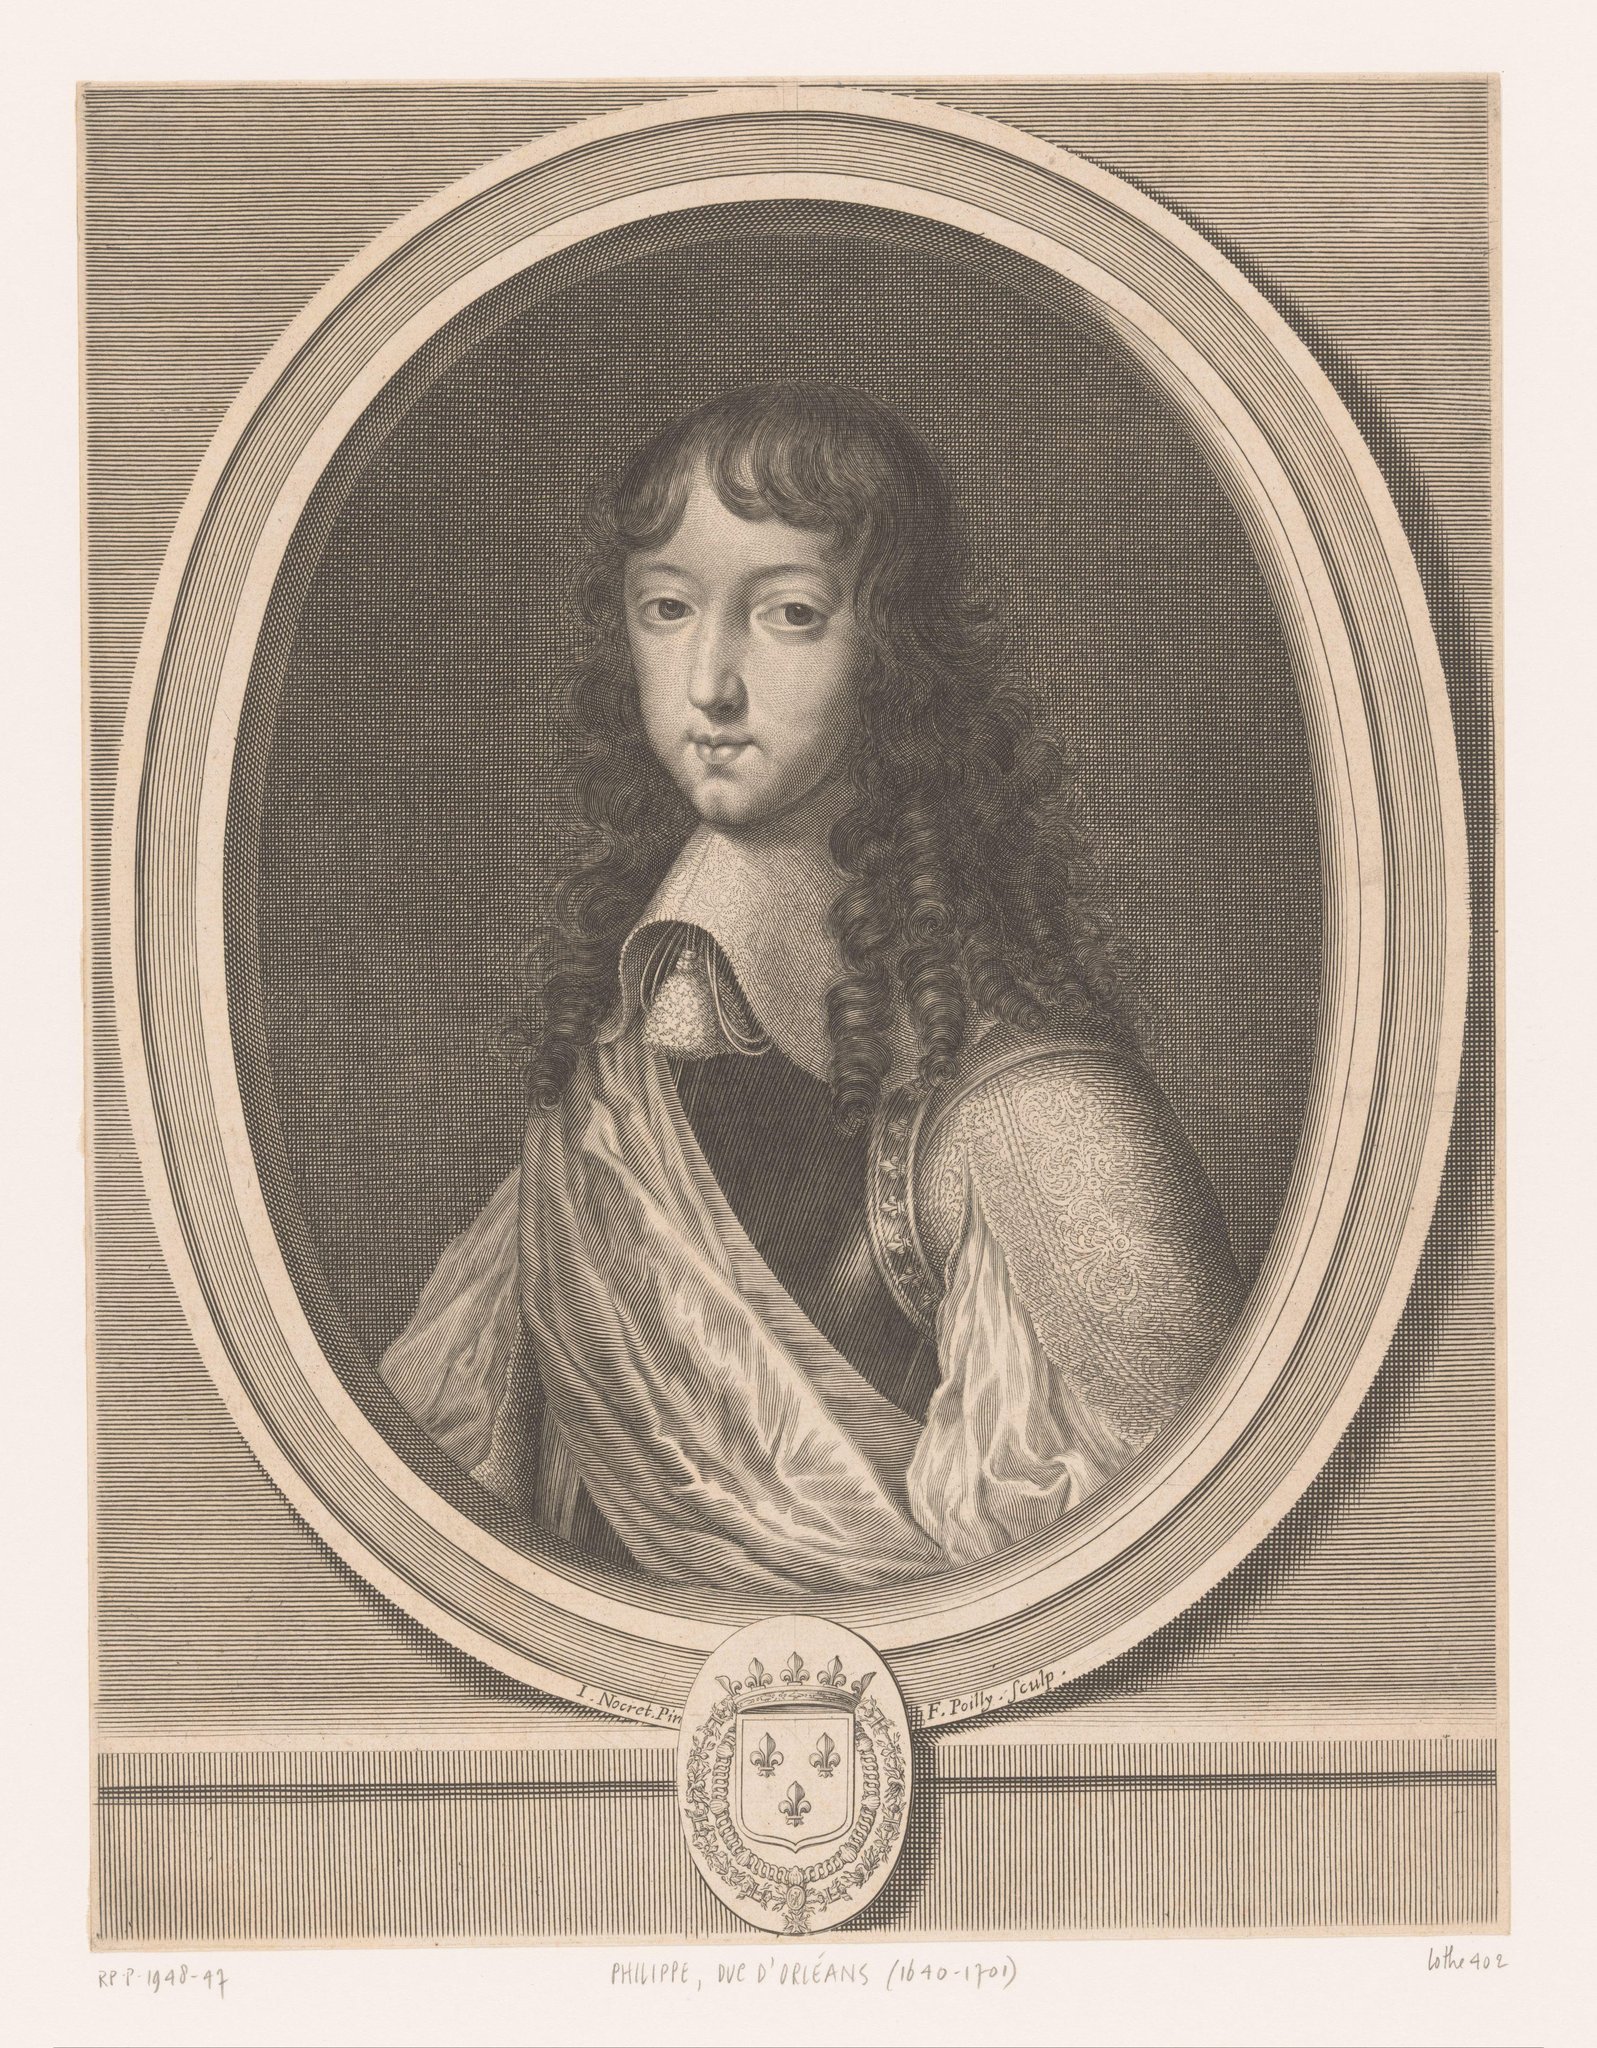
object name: print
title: Portret van Filips van Orléans I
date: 1632-1693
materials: paper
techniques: engraving, etching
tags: filips i (hertog van orléans), historical persons, nobility and patriciate; chivalry, knighthood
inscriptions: collector's mark: Lugt 2228